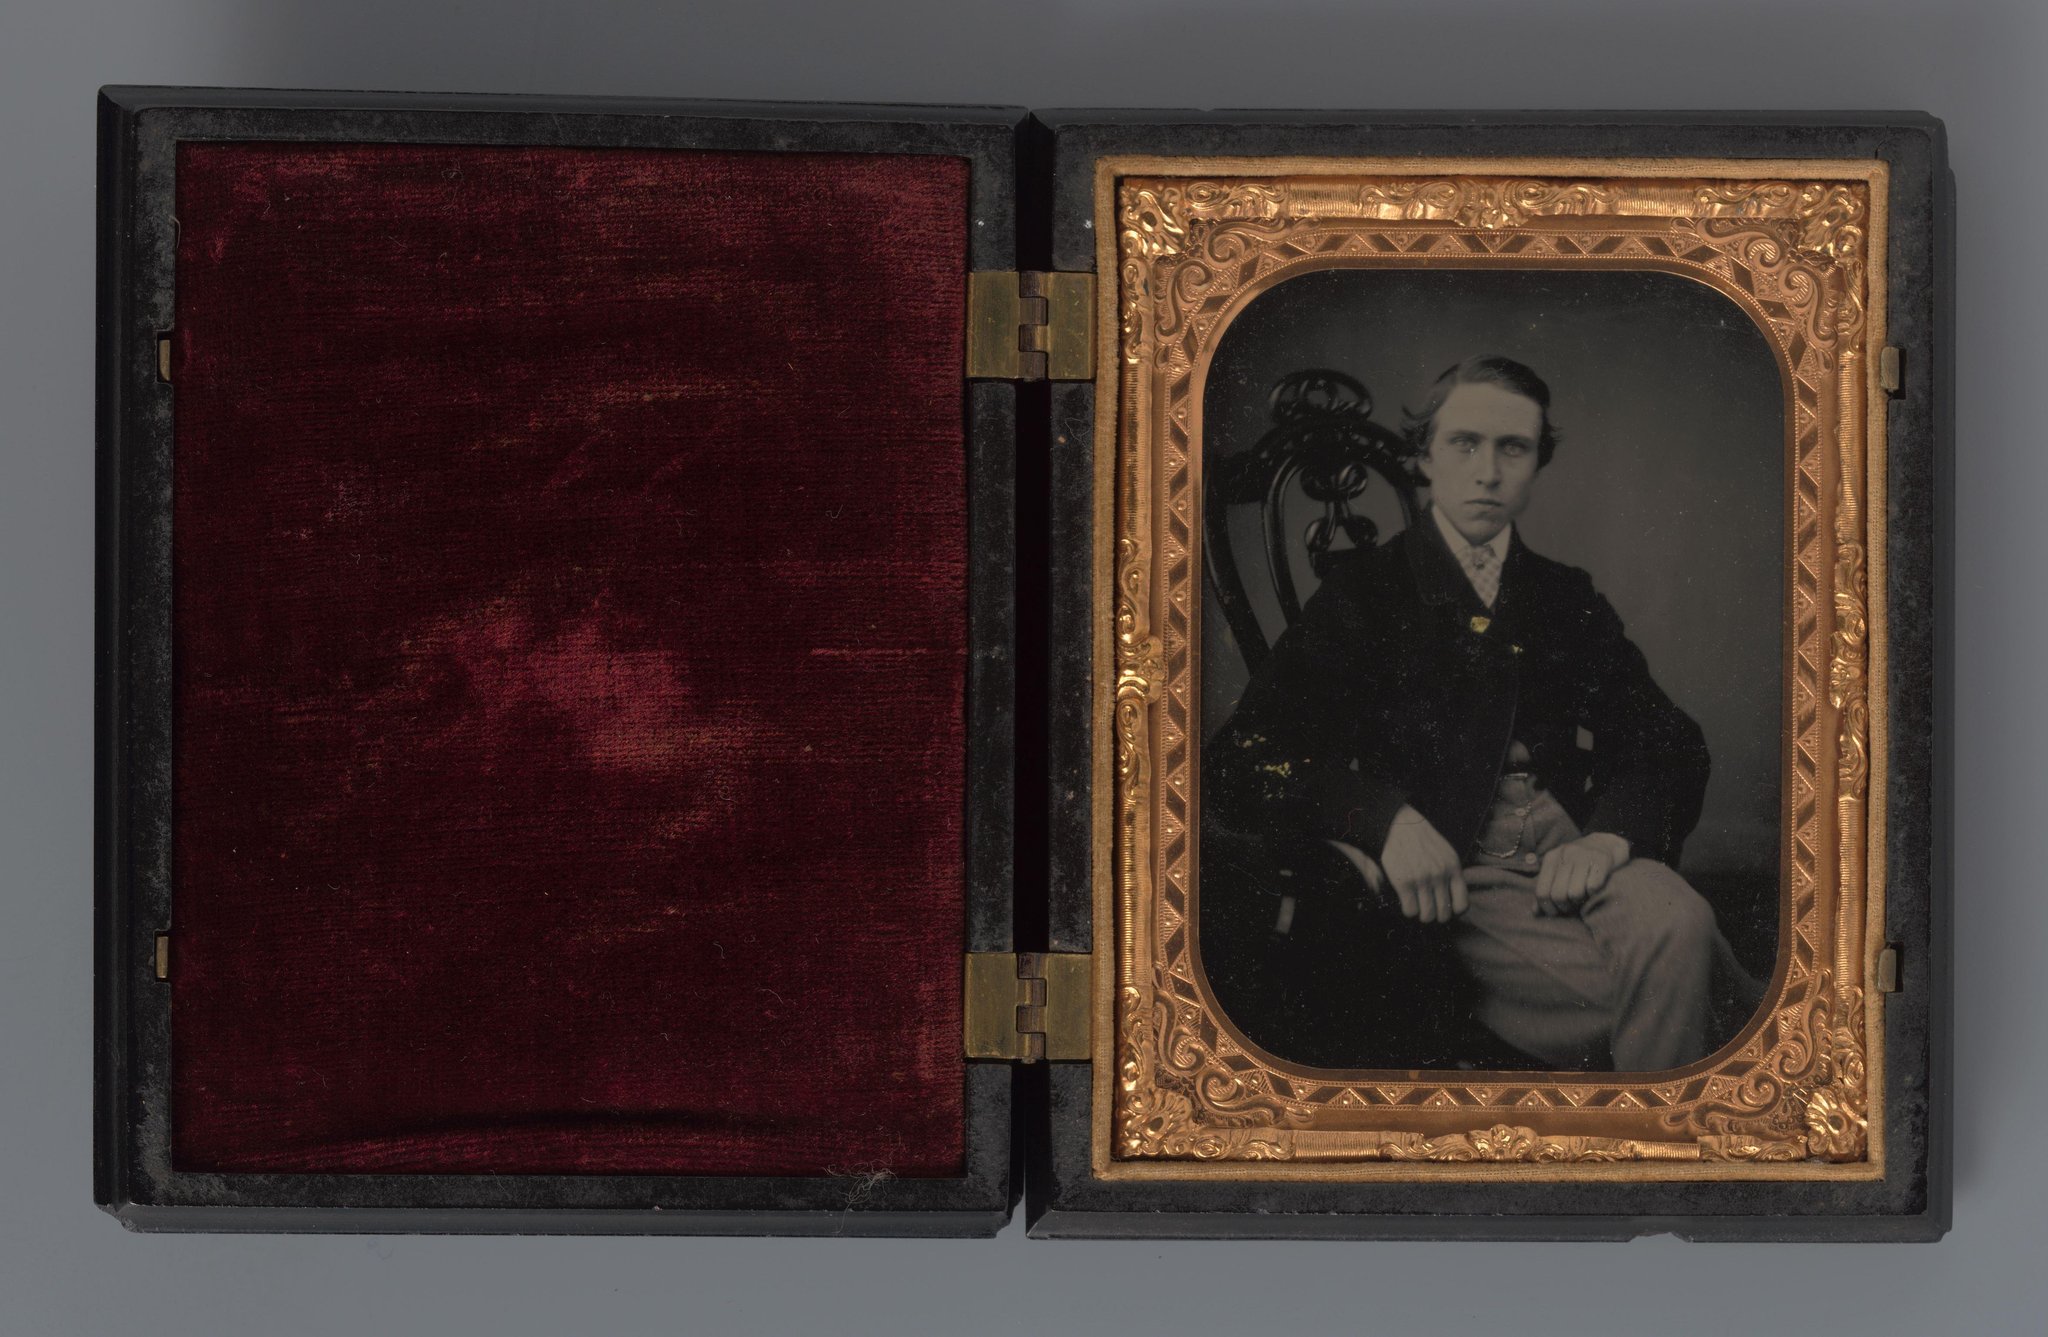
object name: photograph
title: Portret van een onbekende zittende jongeman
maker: Anonymous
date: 1857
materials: glass, metal, plastic, velvet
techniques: ambrotype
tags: sitting figure, historical persons, youth, adolescent